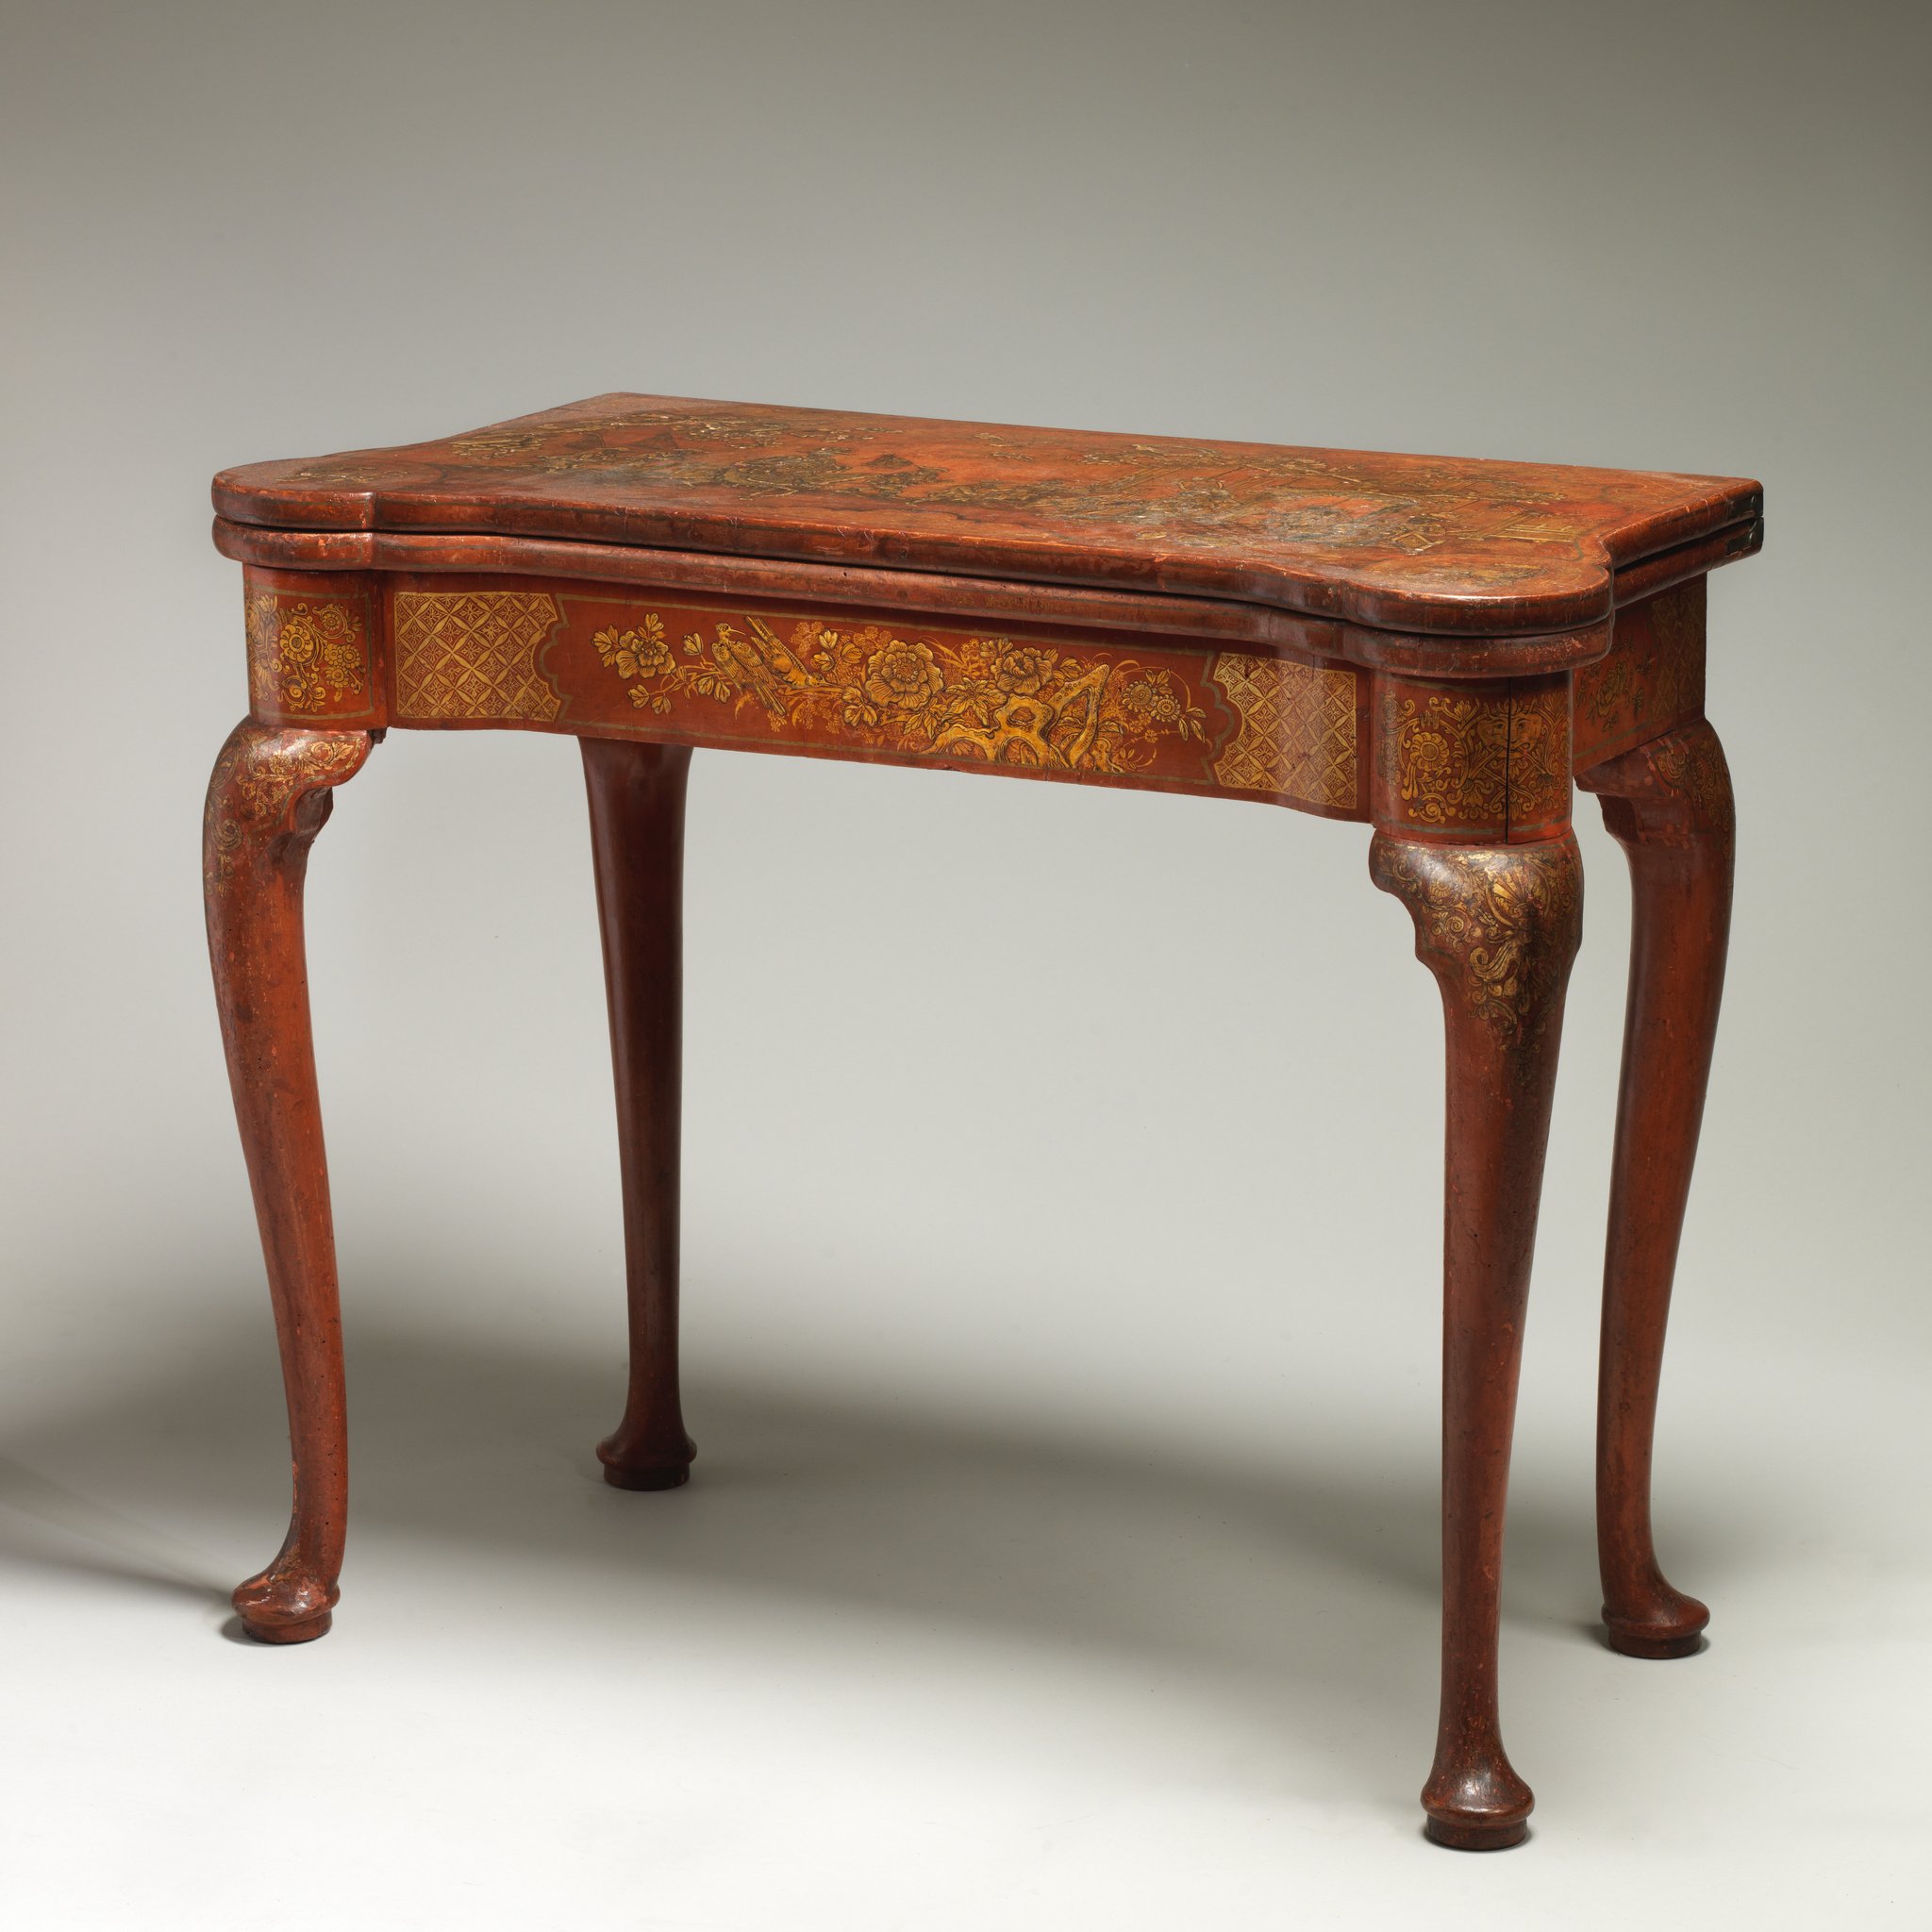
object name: card table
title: Card table (from a large set)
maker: giles grendey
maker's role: artist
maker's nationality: english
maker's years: 1693-1780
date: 1735-1740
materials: wood, felt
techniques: gilding, lacquer